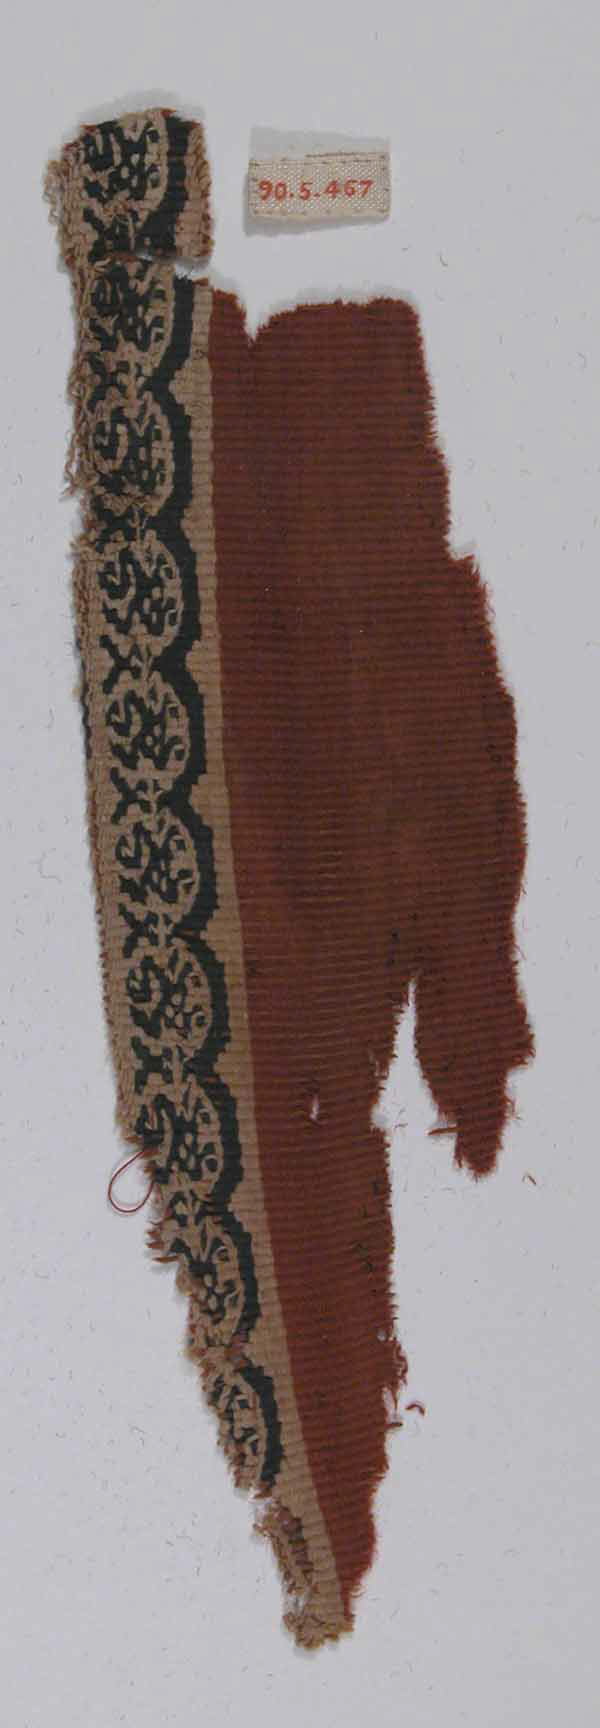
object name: textile fragment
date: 301-500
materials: linen, wool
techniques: weave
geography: egypt